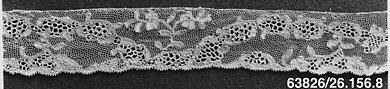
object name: border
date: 1701-1800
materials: silk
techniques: lace